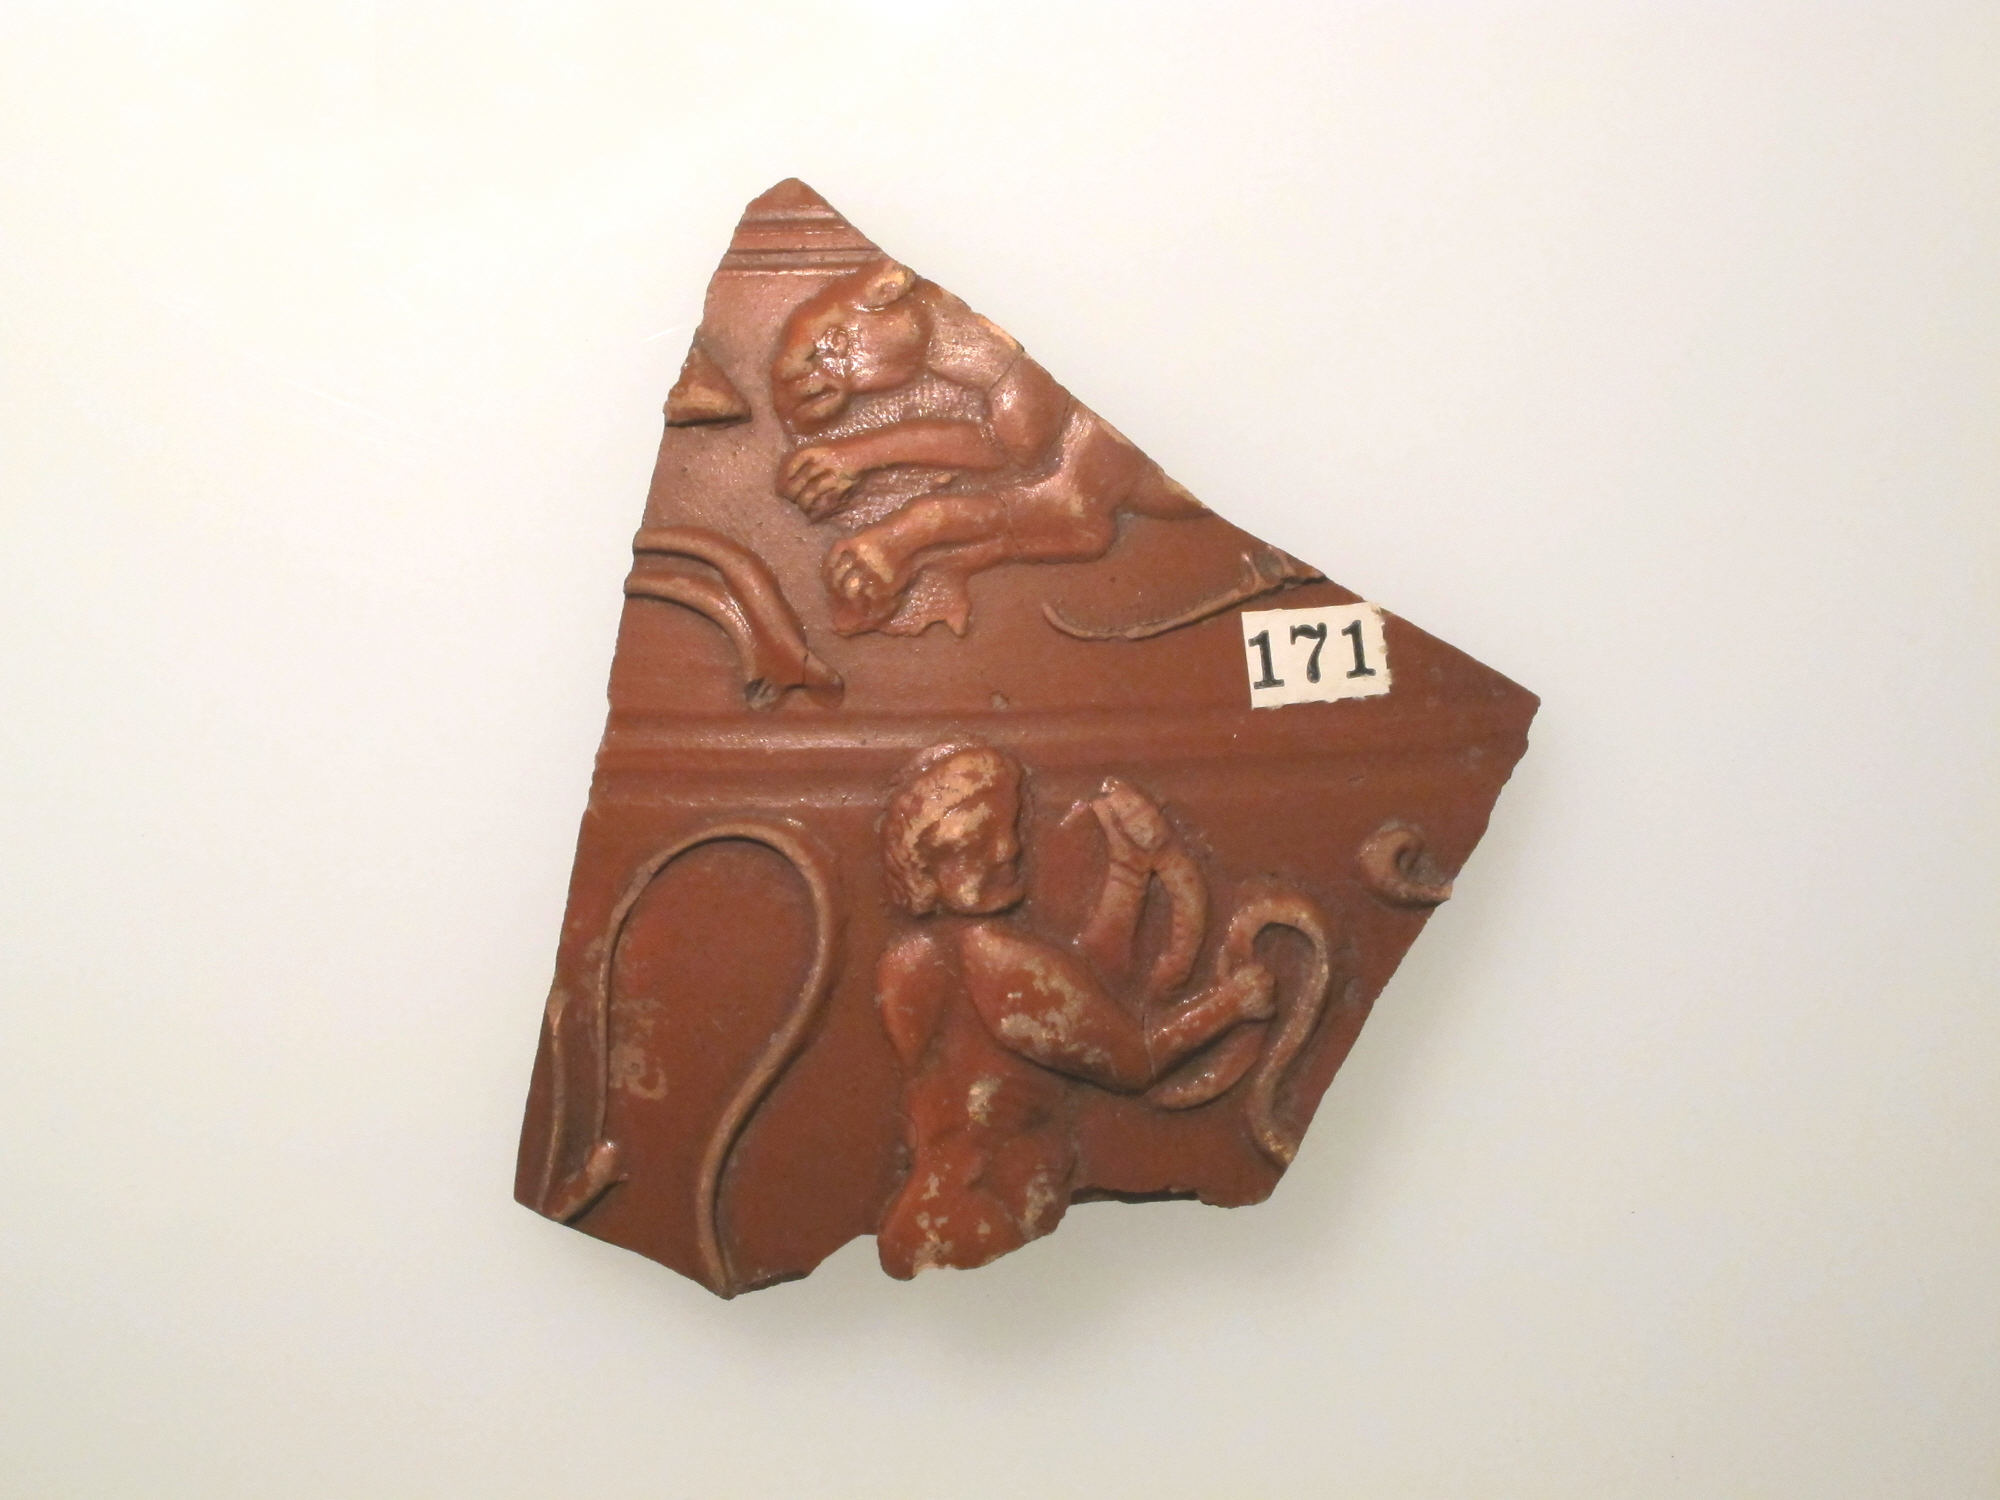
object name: vase fragment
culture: roman, gaul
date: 120 BCE-300 CE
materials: terracotta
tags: human figures,lions,snakes